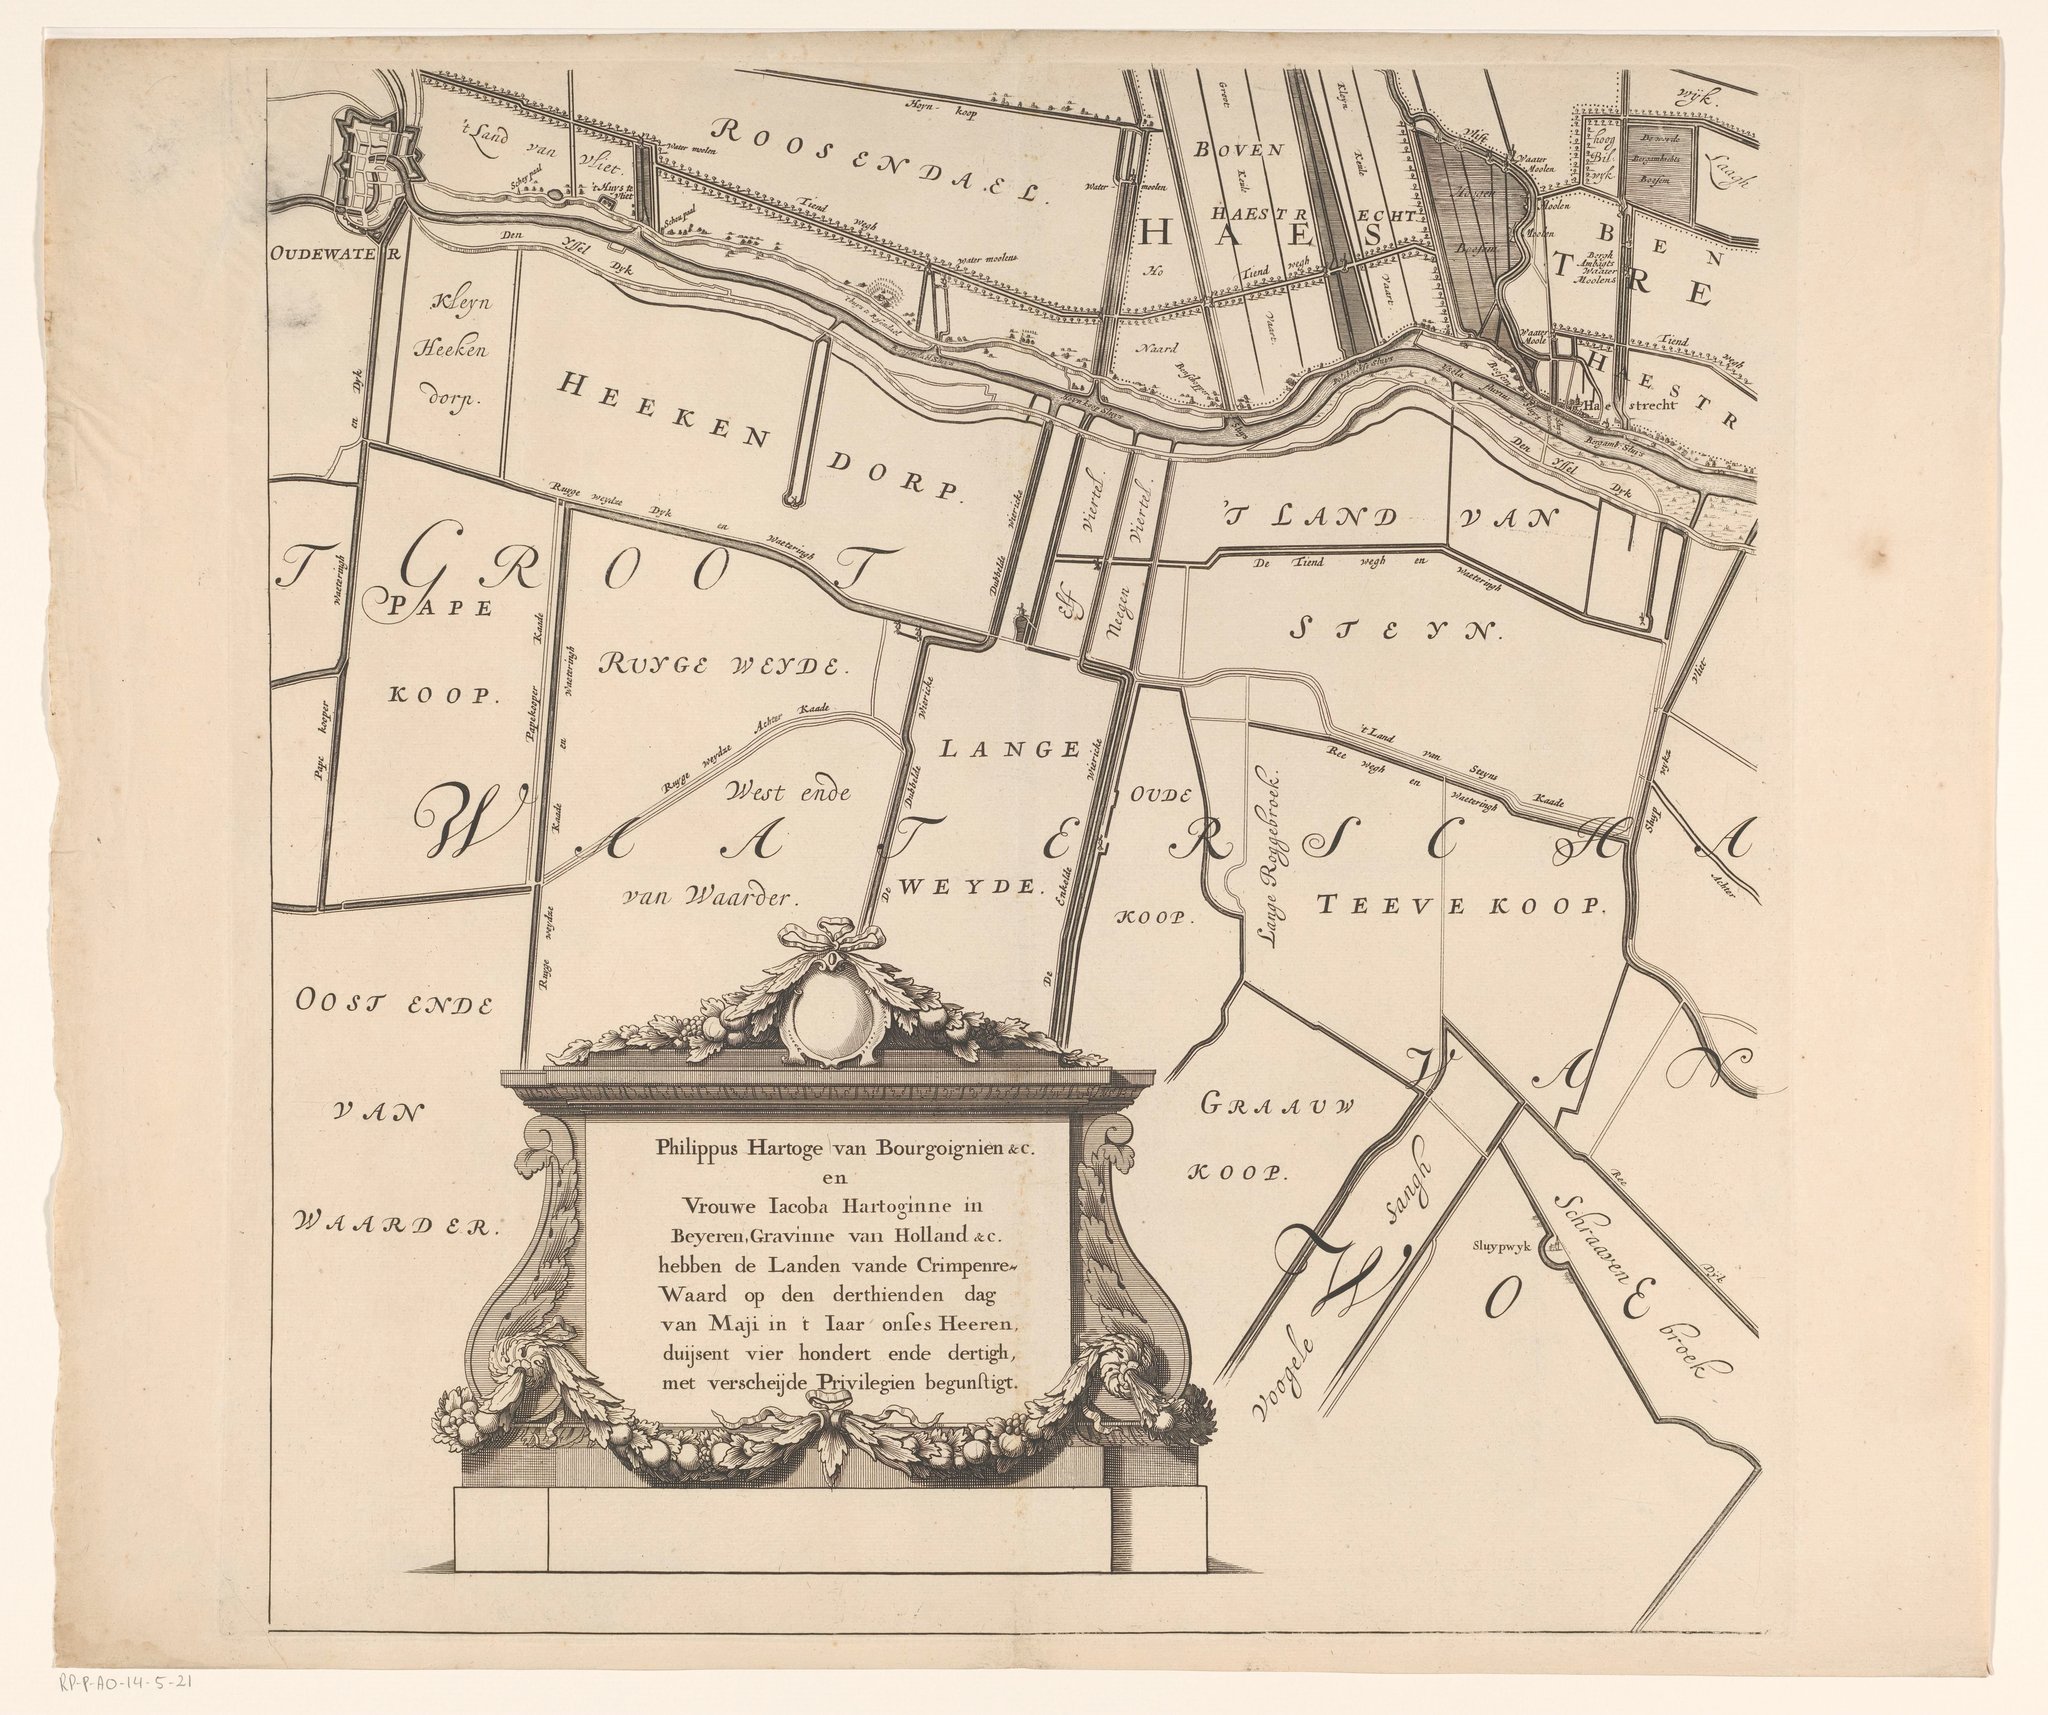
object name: print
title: Het Hooge Heemraadschap van de Crimpenre Waard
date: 1683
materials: paper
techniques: engraving, etching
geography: amsterdam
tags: maps of separate countries or regions, maps of cities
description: Vierde deel van de kaart van de vijfde druk van 'Het Hooge Heemraadschap van de Crimpenre Waard', een wandkaart (bestaande uit een zesdelige kaart en een wapenrand) van het Hoogheemraadschap van de Krimpenerwaard.